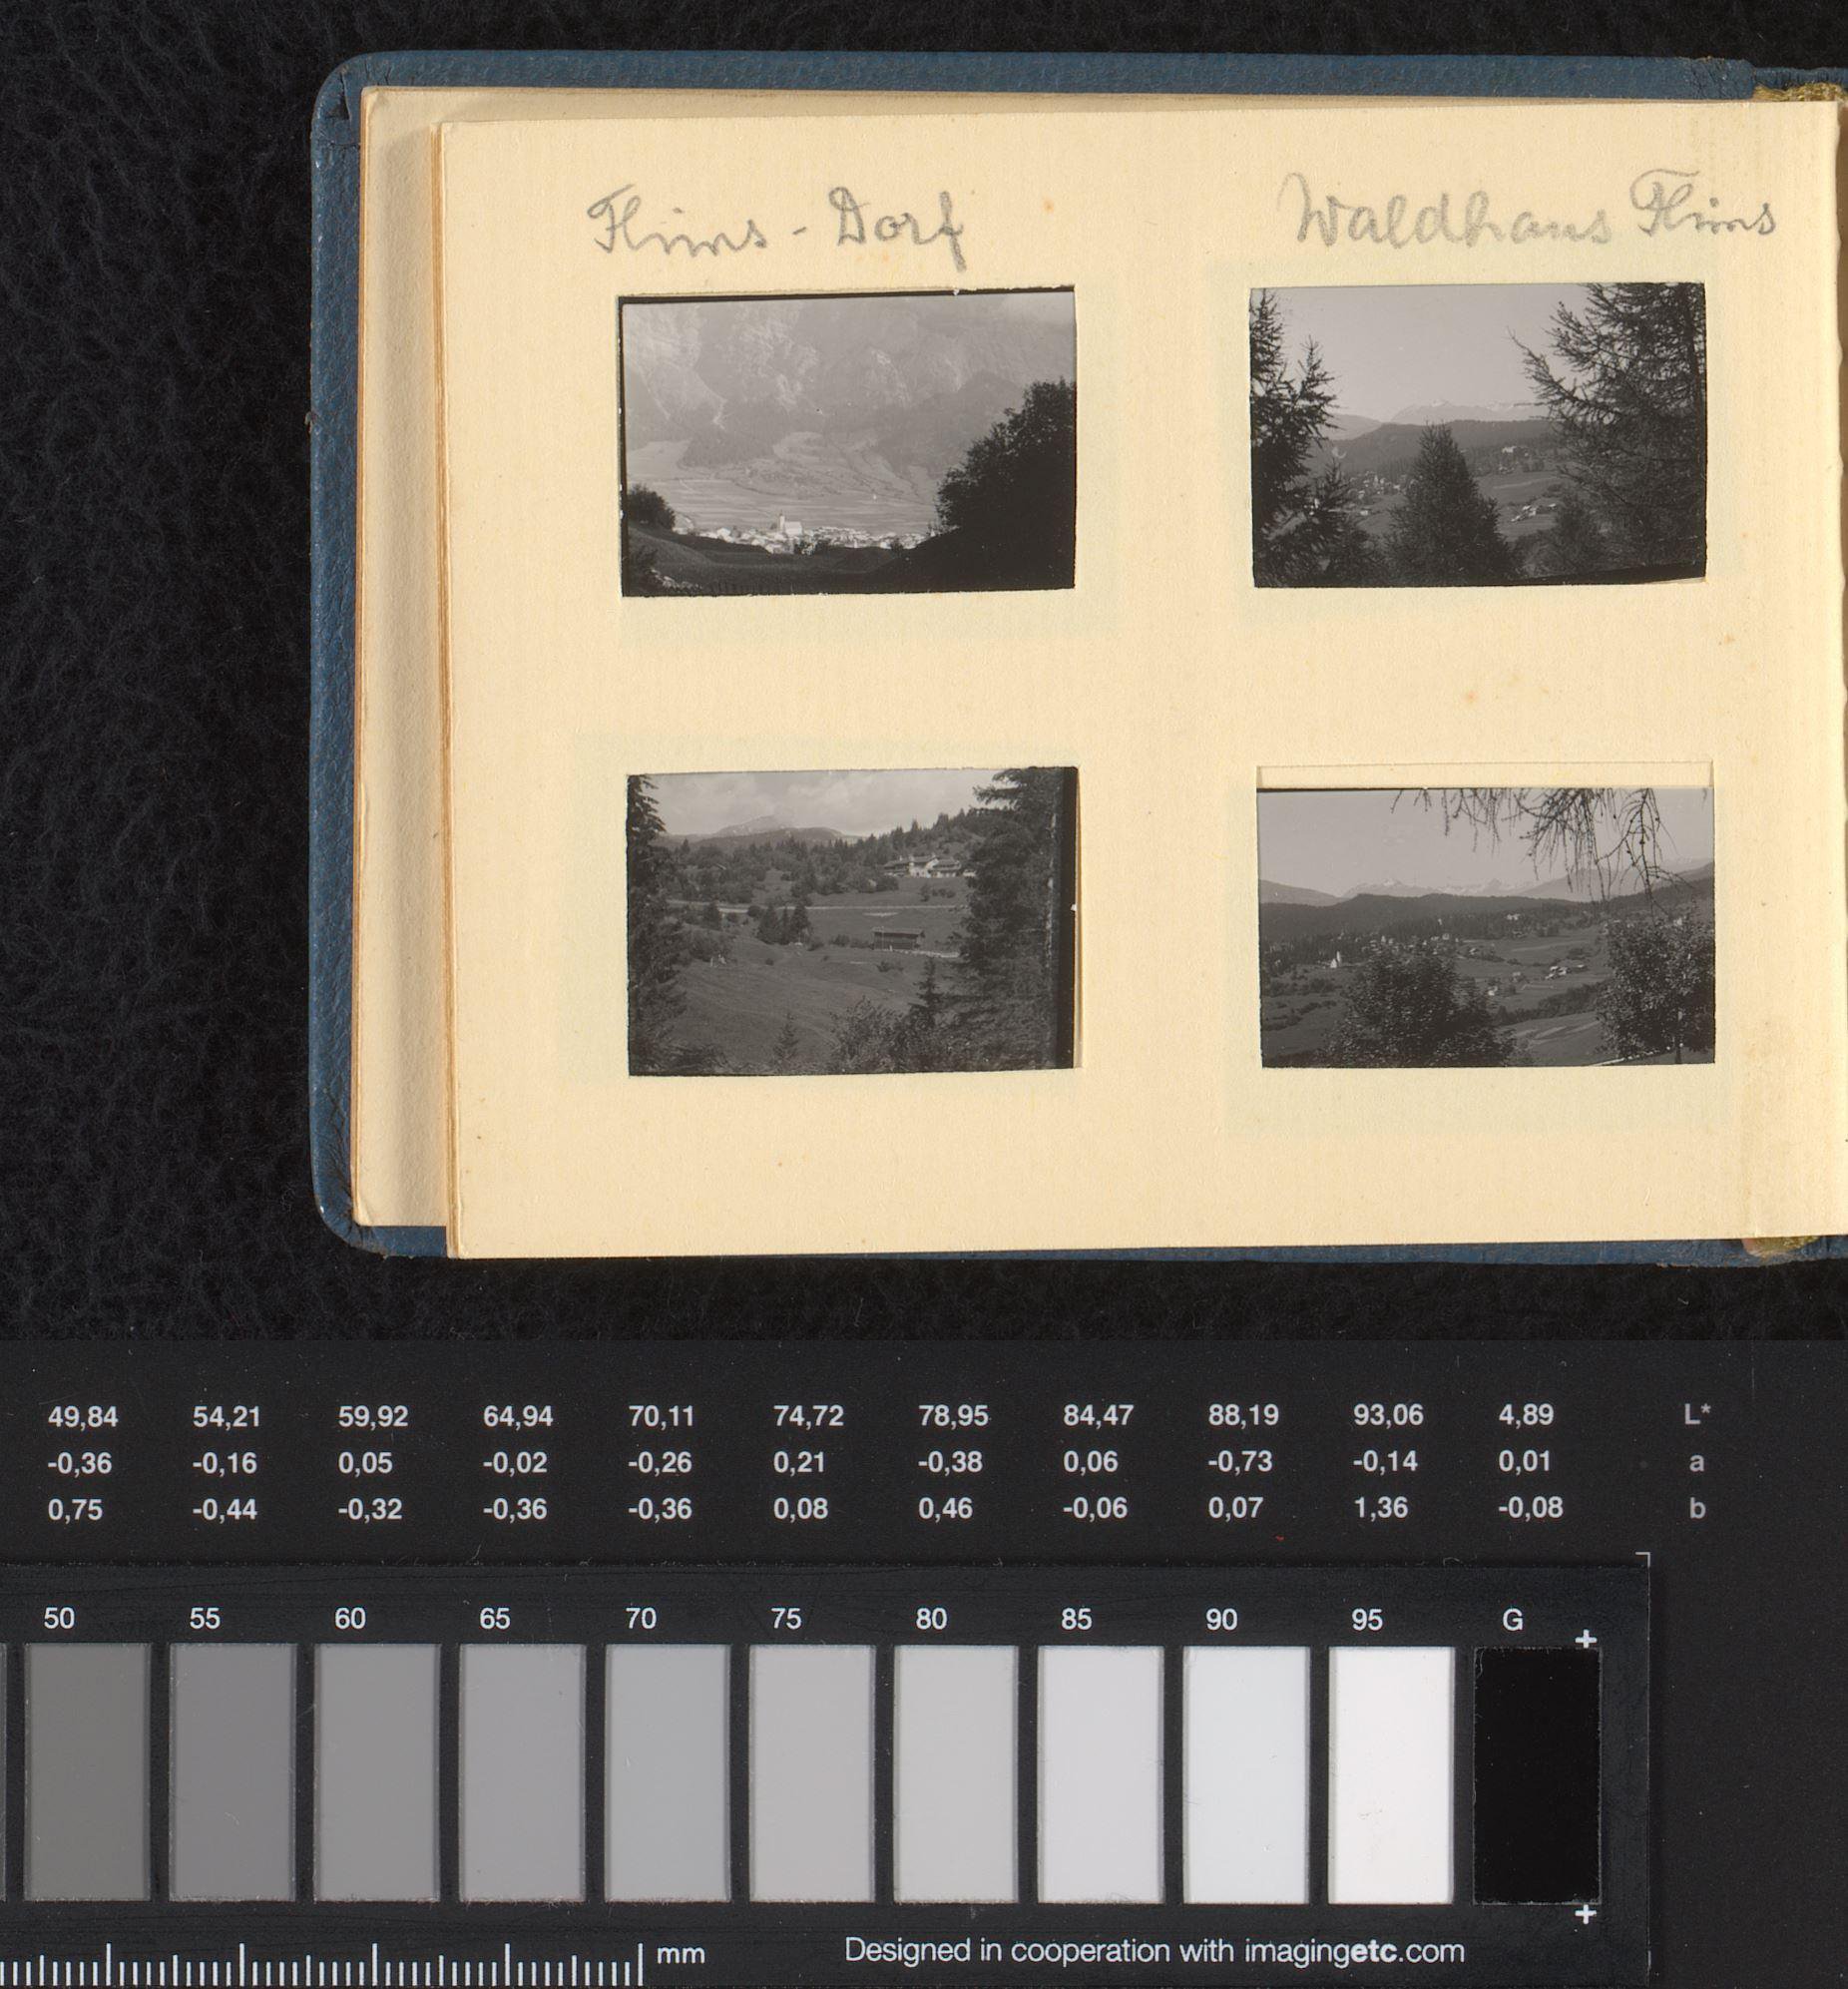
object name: photograph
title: Zwitserse plaatsen Flims-Dorf en Flims-Waldhaus, tijdens een vakantie van de familie Wachenheimer, augustus 1936, Zwitserland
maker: else wachenheimer-moos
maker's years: 1895-1944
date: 1908-1936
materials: paper, photographic support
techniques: gelatin silver print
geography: switzerland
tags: the family travelling, on holiday, mountain-range, snow peaks, switzerland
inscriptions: inscription: ‘Flims-Dorf / Waldhaus-Flims’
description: Albumblad bevat vier foto's. Zonder personen gerelateerd aan de familie Wachenheimer. Uit klein formaat fotoalbum, blauw lederen omslag met drukknopsluiting. Met foto's in klein formaat.